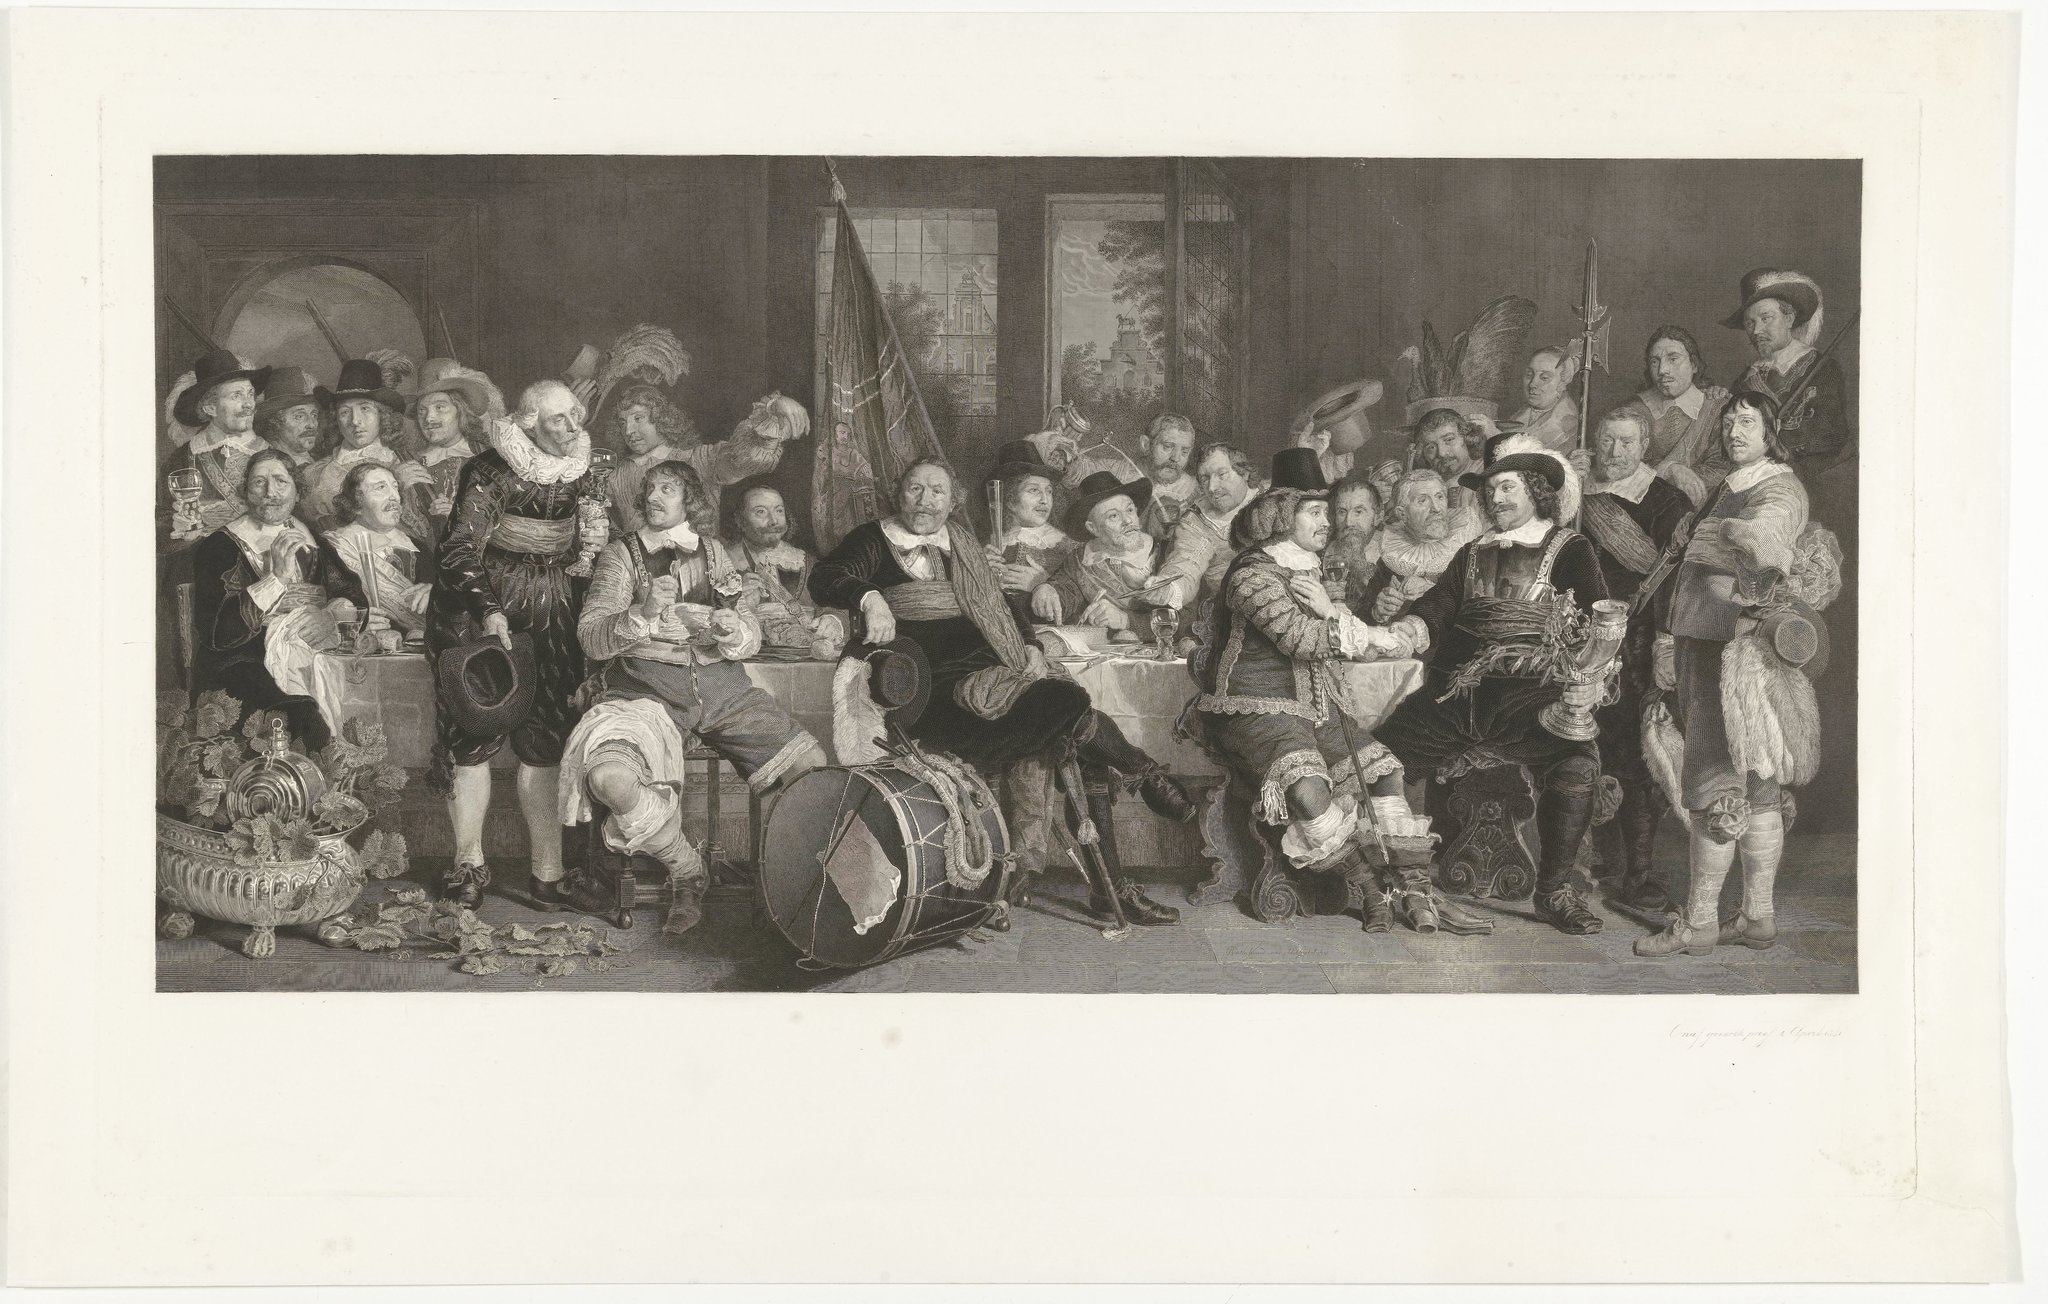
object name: historical object representation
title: De schuttersmaaltijd in de Voetboog- of St. Jorisdoelen te Amsterdam ter viering van het sluiten van de vrede van Munster, 18 juni 1648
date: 1851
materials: paper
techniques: engraving, etching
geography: netherlands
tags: warfare; military affairs (+ citizen soldiery, civil guard, citizen militia), celebration meal, feast, banquet, festivities on events of national importance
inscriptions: inscription: ‘Onaf gewerkte proef 4 April 1851’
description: Het schilderij van de schuttersmaaltijd in de Voetboogdoelen of St. Jorisdoelen te Amsterdam ter viering van het sluiten van de vrede van Munster, 18 juni 1648. Voorgesteld zijn: kapitein Cornelis Jansz Witsen (met de zilveren drinkhoorn), luitenant Johan Oetgens van Waveren (die zijn hand schudt), de vaandrig Jacob Banningh (zittend naast de grote trommel), Dirck Claesz Thoveling en Thomas Hartog (sergeanten), Pieter van Hoorn, Willem Pietersz van der Voort, Adriaen Dirck Sparwer, Hendrick Calaber, Govert van der Mij, Johannes Calaber, Benedictus Schaeck, Jan Maes, Jacob van Diemen, Jan van Ommeren, Isaac Ooyens, Gerrit Pietersz van Anstenraadt, Herman Teunisz de Kluyter, Andries van Anstenraadt, Christoffel Poock, Hendrick Dommer Wz, Paulus Hennekijn, Lambregt van den Bos en Willem (de trommelslager). Op de grote trommel hangt een papier met een gedicht van Jan Vos. Door de openstaande ramen is de gevel van de brouwerij 'het Lam' aan de Singel zichtbaar. Rechts brengt een vrouwen een kalkoenpastei binnen. Op tafel staan tinnen borden, roemers en andere glazen. Links staat op de vloer een grote metalen koeler met een wijnvat.